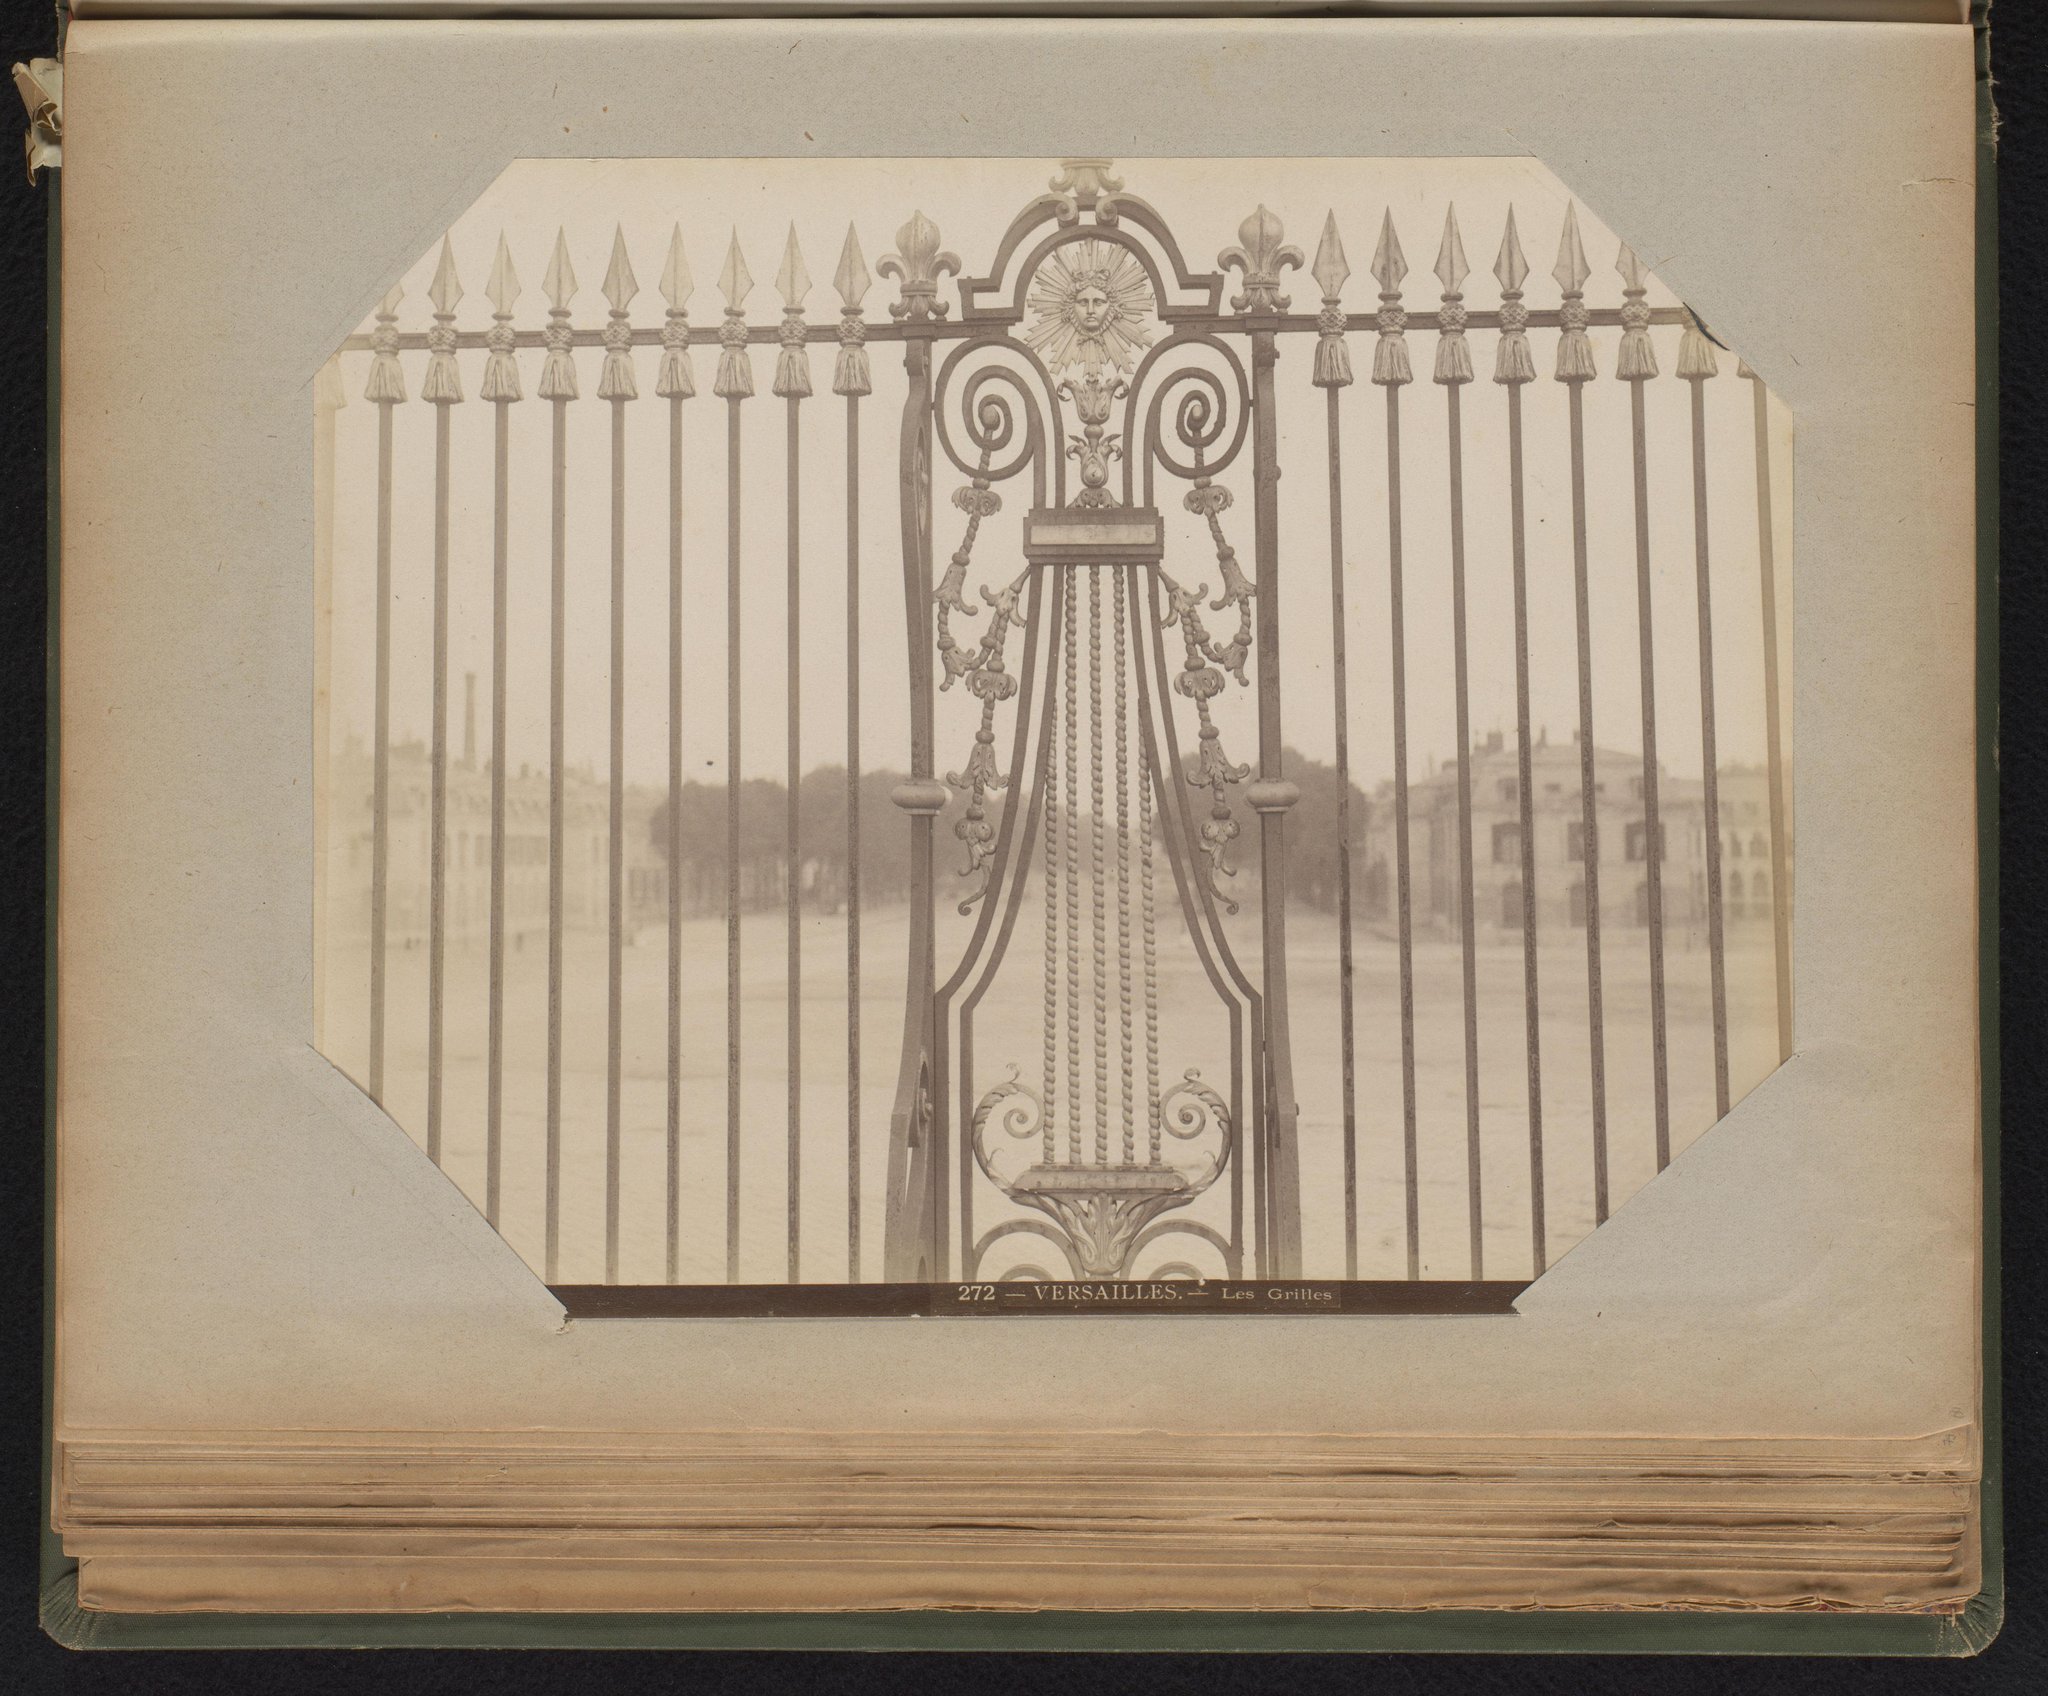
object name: photograph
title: Het hekwerk van paleis Versailles met ornamenten in de vorm van franse lelies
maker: Anonymous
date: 1860-1900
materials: paper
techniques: albumen print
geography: france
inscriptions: annotation: ‘272. - Versailles - Les Grilles’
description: Onderdeel van een serie met betrekking tot het interieur van het paleis van Versailles met kroonluchters, deuren, portalen en meubelstukken.